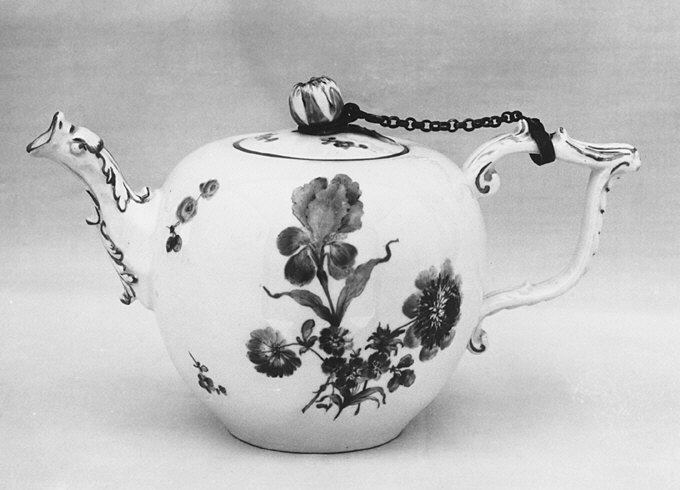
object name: teapot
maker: meissen manufactory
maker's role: manufactory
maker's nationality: german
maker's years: 1710-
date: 1750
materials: hard paste porcelain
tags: flowers